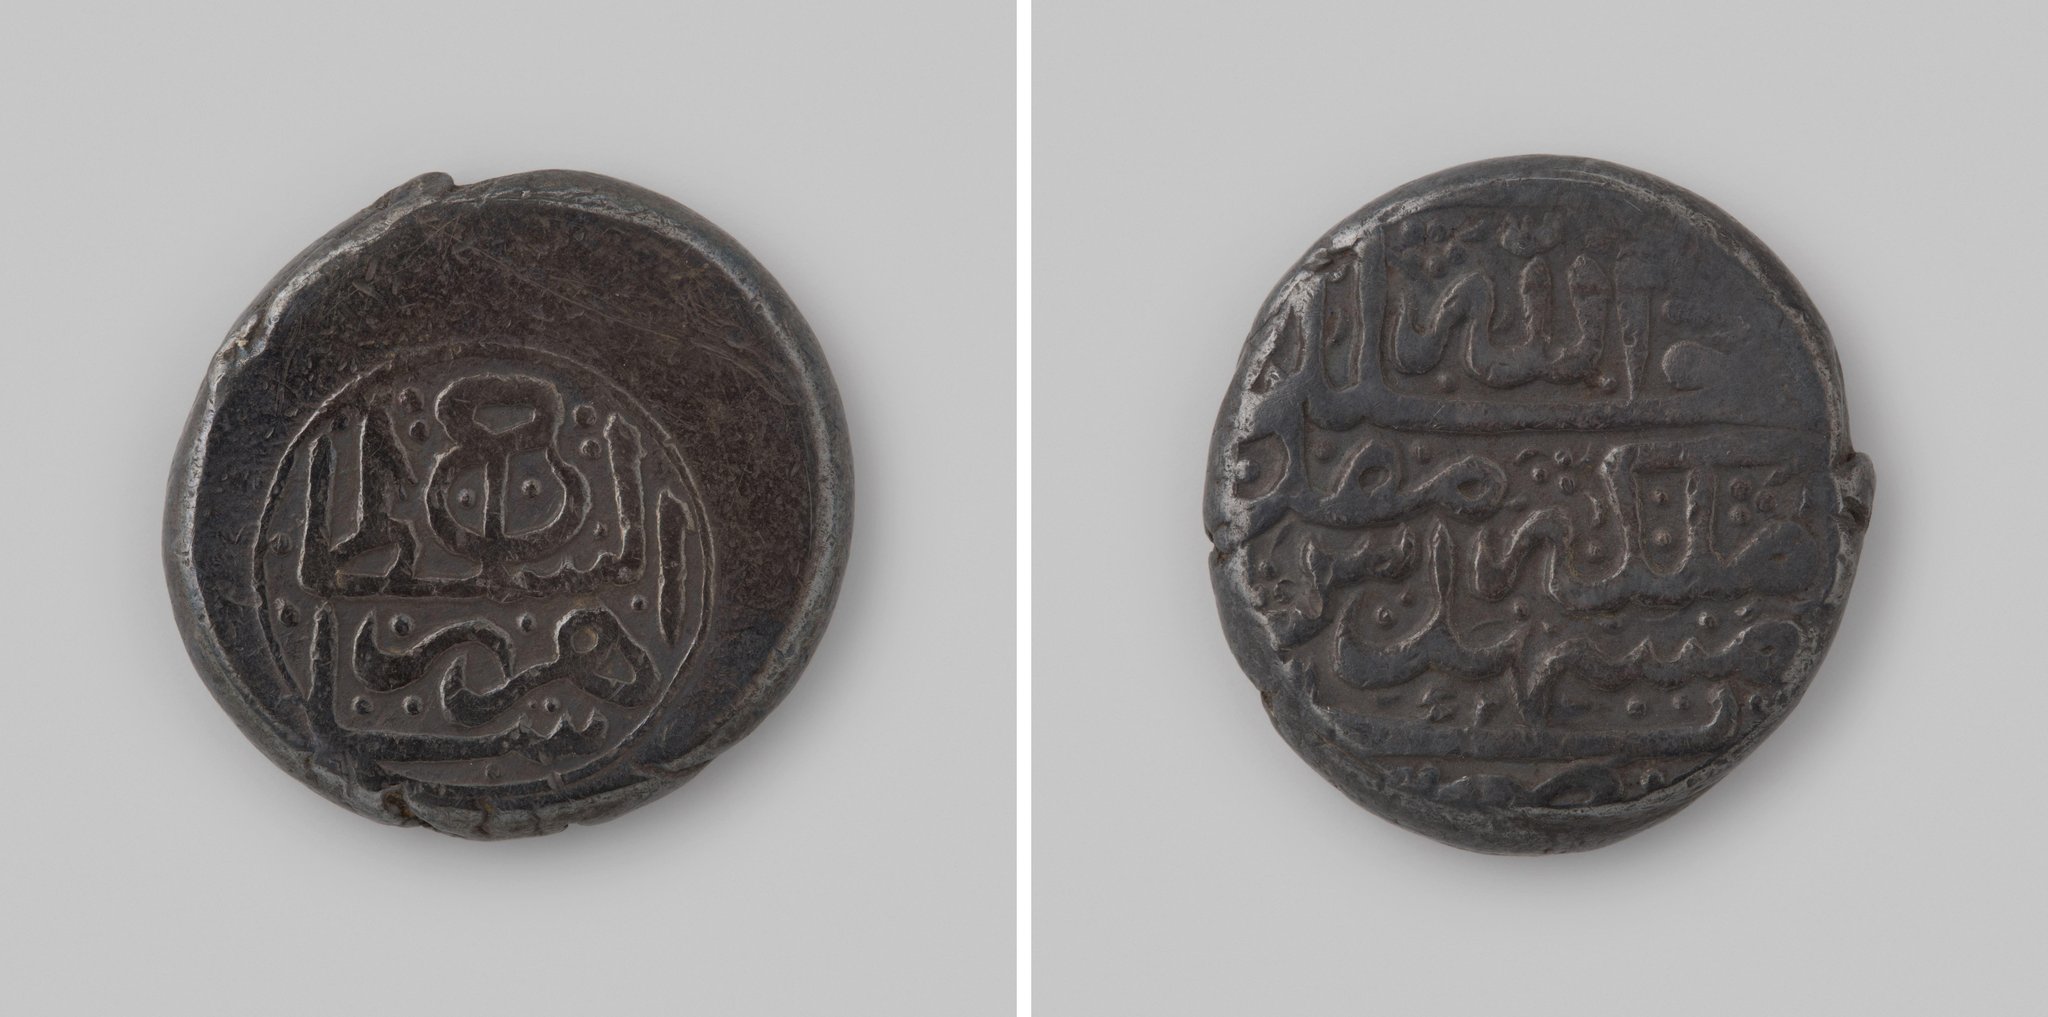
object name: coin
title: Perzië, sjah Rukh, 1161-1163 AH [=1748-1750], 2 rupi,1161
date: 1748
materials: silver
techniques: striking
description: Zilveren munt. Voorzijde: binnen cirkel in drie regels opschrift. Rondom cirkel brede, gladde rand. Keerzijde: in Arabische lettertekens in twee regels rijmdicht. Daaronder muntplaats-aanduiding: Mashad, waaronder jaartal. Gladde rand.